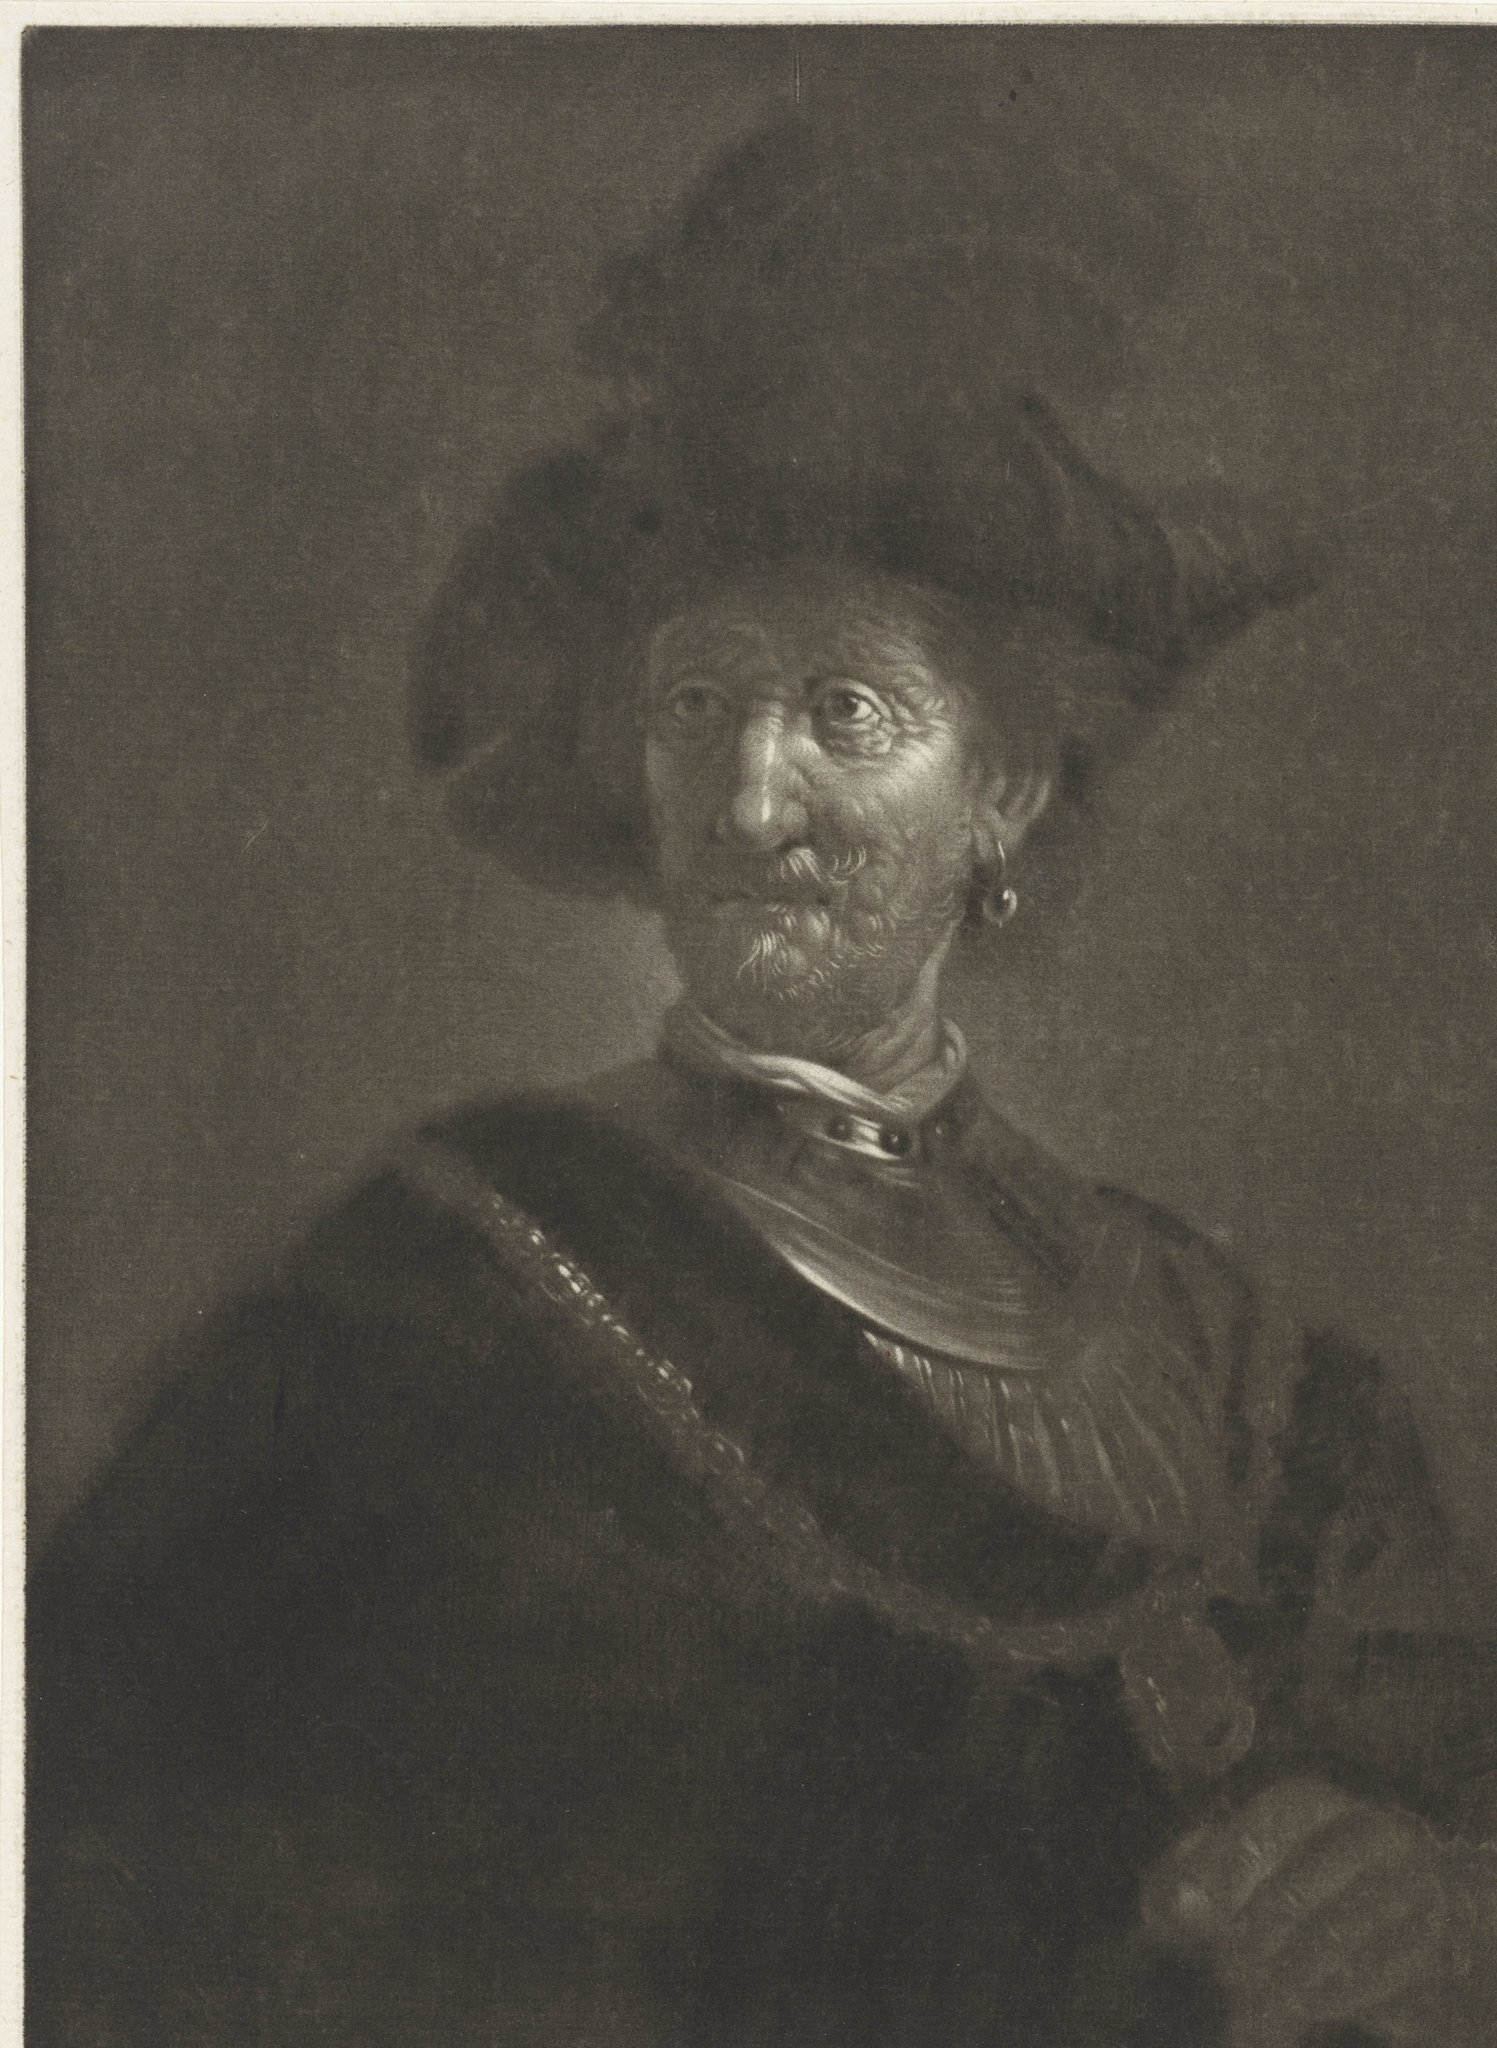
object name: print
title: Portret van een man, mogelijk Rembrandts vader, Harmen Gerritsz. van Rijn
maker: jan stolker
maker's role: draughtsman, painter, print maker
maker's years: 1724-1785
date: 1734-1785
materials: paper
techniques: mezzotint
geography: northern netherlands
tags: head-gear: hat (+ men's clothes), ear-rings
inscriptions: collector's mark: Lugt 2228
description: Een man, mogelijk Rembrandts vader, Harmen Gerritsz van Rijn met een gevederde hoed, een halsketen en een oorbel.